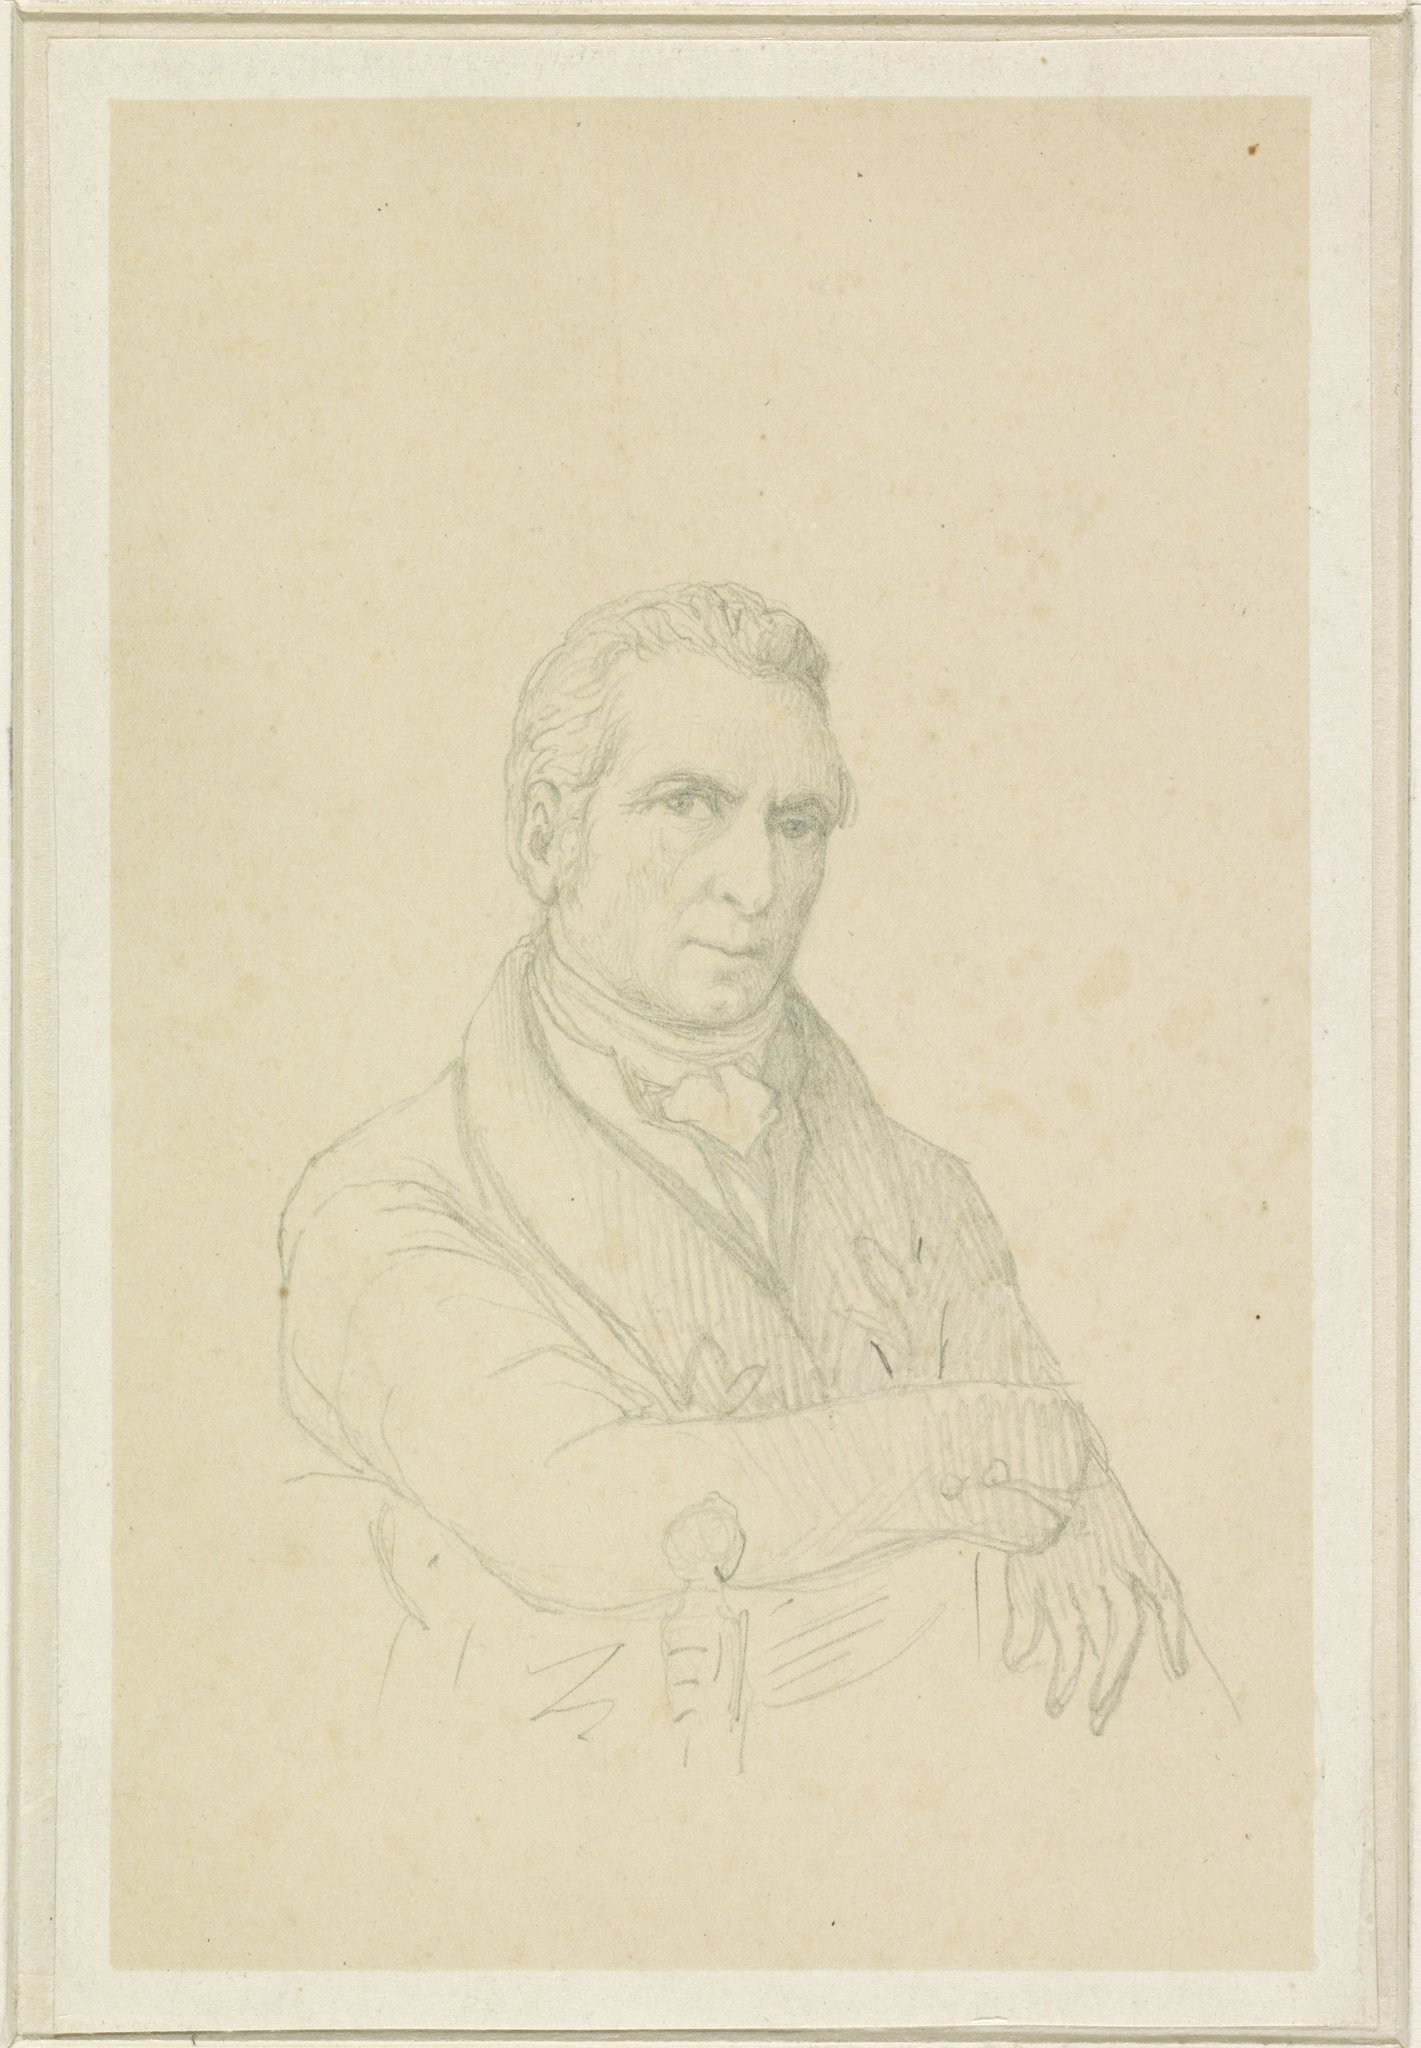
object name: drawing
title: Portret van Johannes Jelgerhuis Rienksz.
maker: johannes jelgerhuis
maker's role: draughtsman, painter, print maker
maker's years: 1770-1836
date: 1830-1836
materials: paper, pencil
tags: amsterdam, painter, draughtsman, johannes jelgerhuis, historical persons, portrait, self-portrait of painter, portrait, self-portrait of artist, portrait, self-portrait of draughtsman